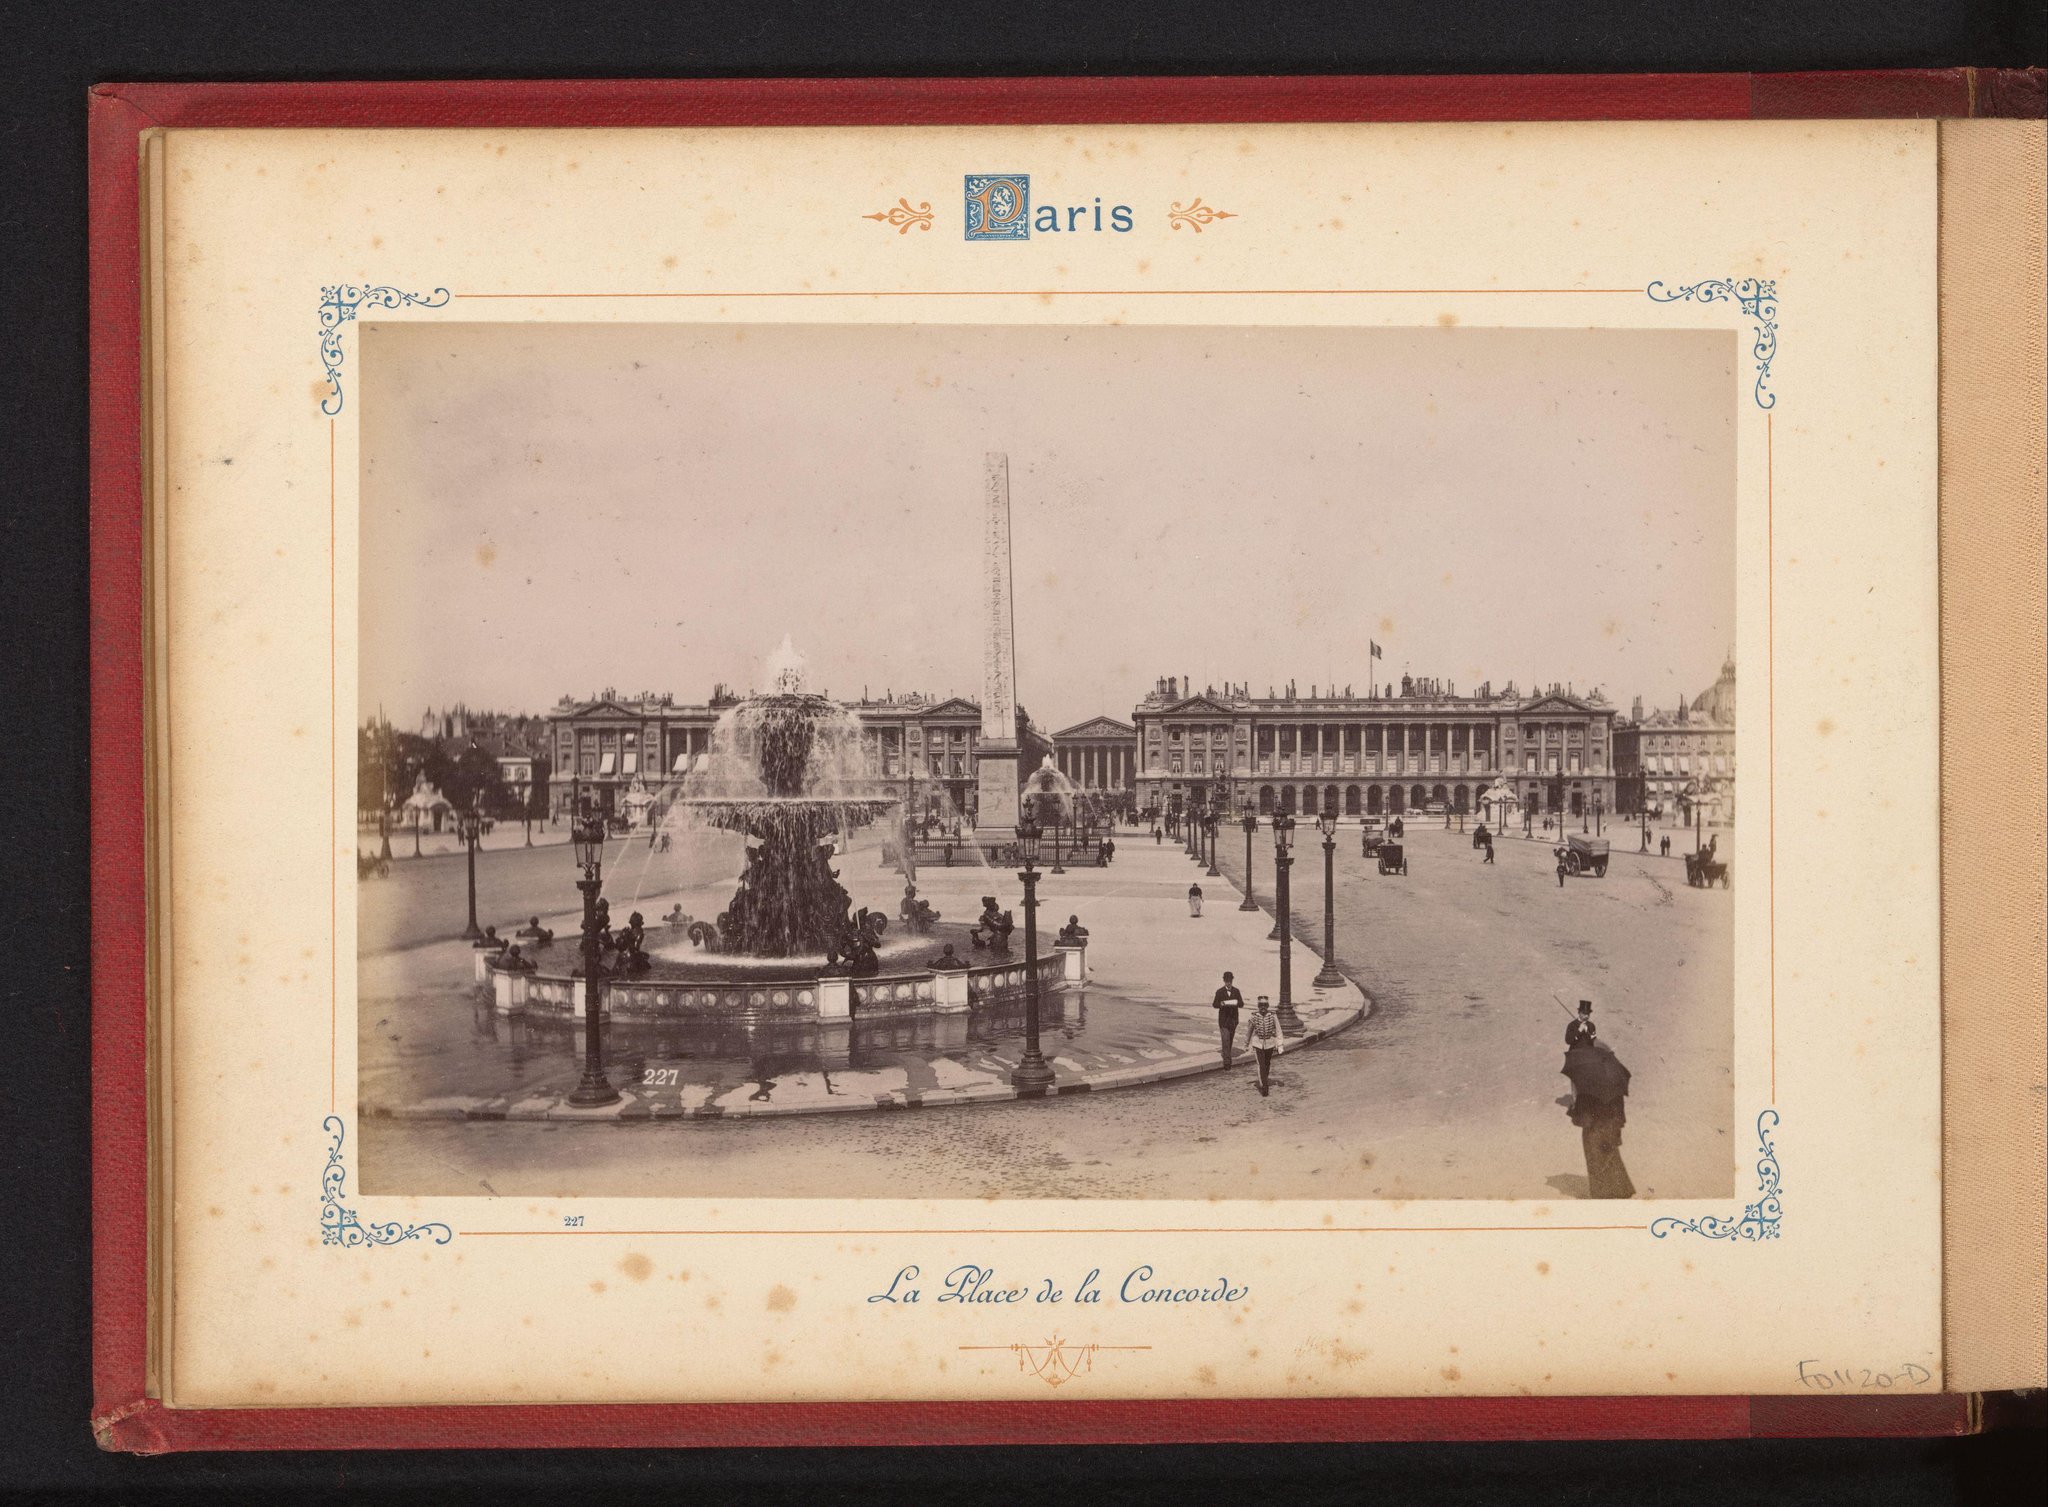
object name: photograph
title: La Place de la Concorde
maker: Anonymous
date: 1885-1900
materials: cardboard, photographic support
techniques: albumen print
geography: paris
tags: obelisk, needle (+ city(-scape) with figures, staffage), square, place, circus, etc. (+ city(-scape) with figures, staffage)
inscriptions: number: ‘227’, number: ‘227’